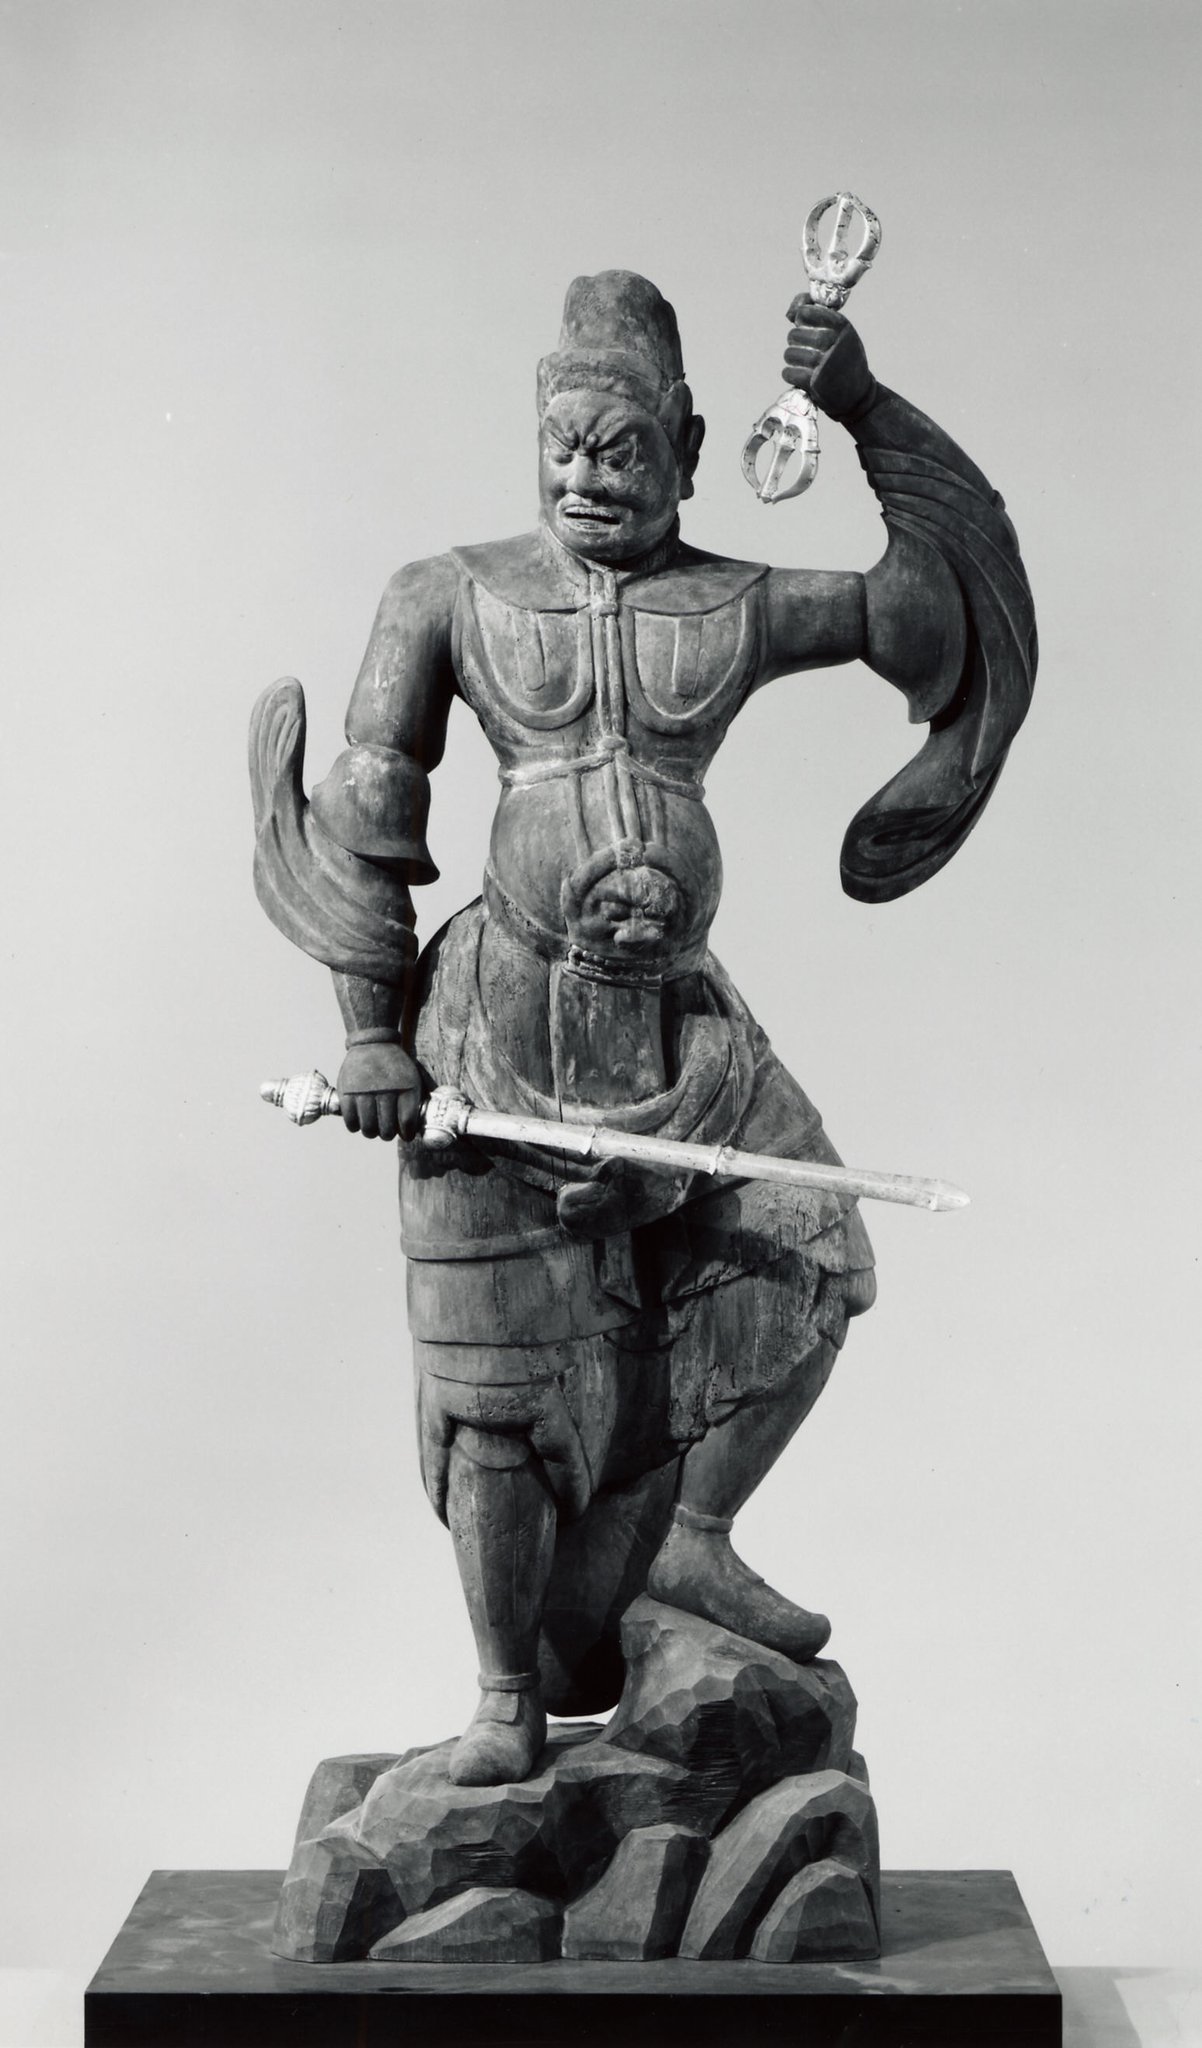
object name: figure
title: Guardian Figure (Ni-Ten)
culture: japanese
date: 1001-1100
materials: wood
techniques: painting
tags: swords